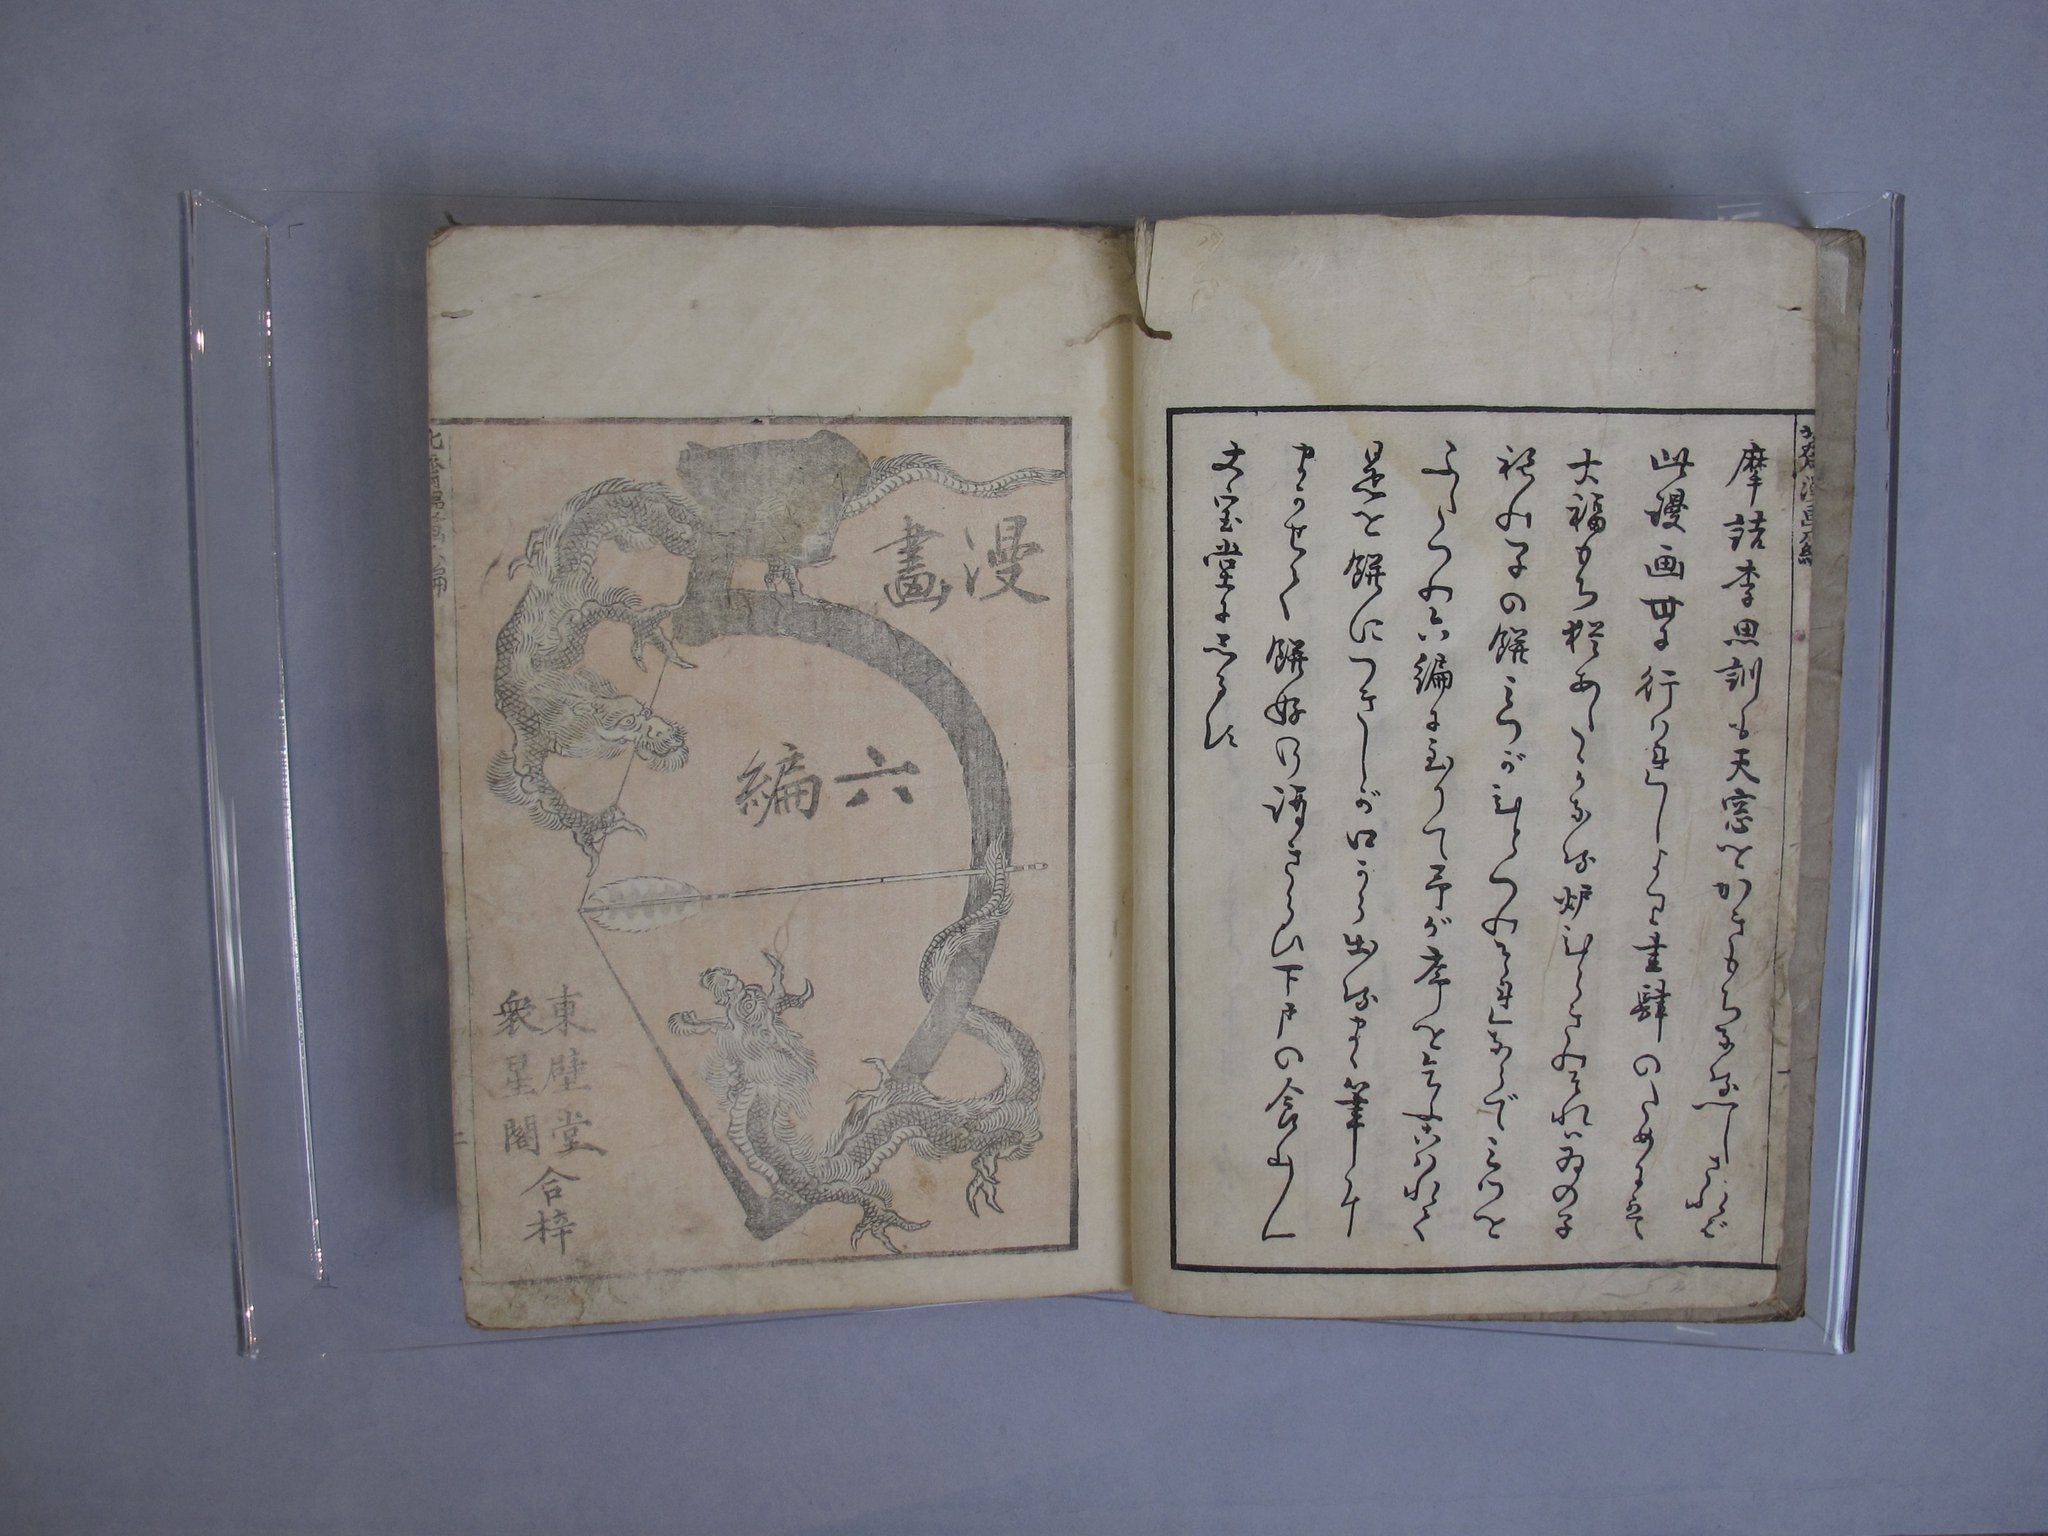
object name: illustrated book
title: Transmitting the Spirit, Revealing the Form of Things: Hokusai Sketchbooks, volume 6 (Denshin kaishu: Hokusai manga, rokuhen)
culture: japanese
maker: katsushika hokusai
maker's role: artist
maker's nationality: japanese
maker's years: 1760-1849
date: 1615-1868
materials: ink, paper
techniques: woodblock print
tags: dragons